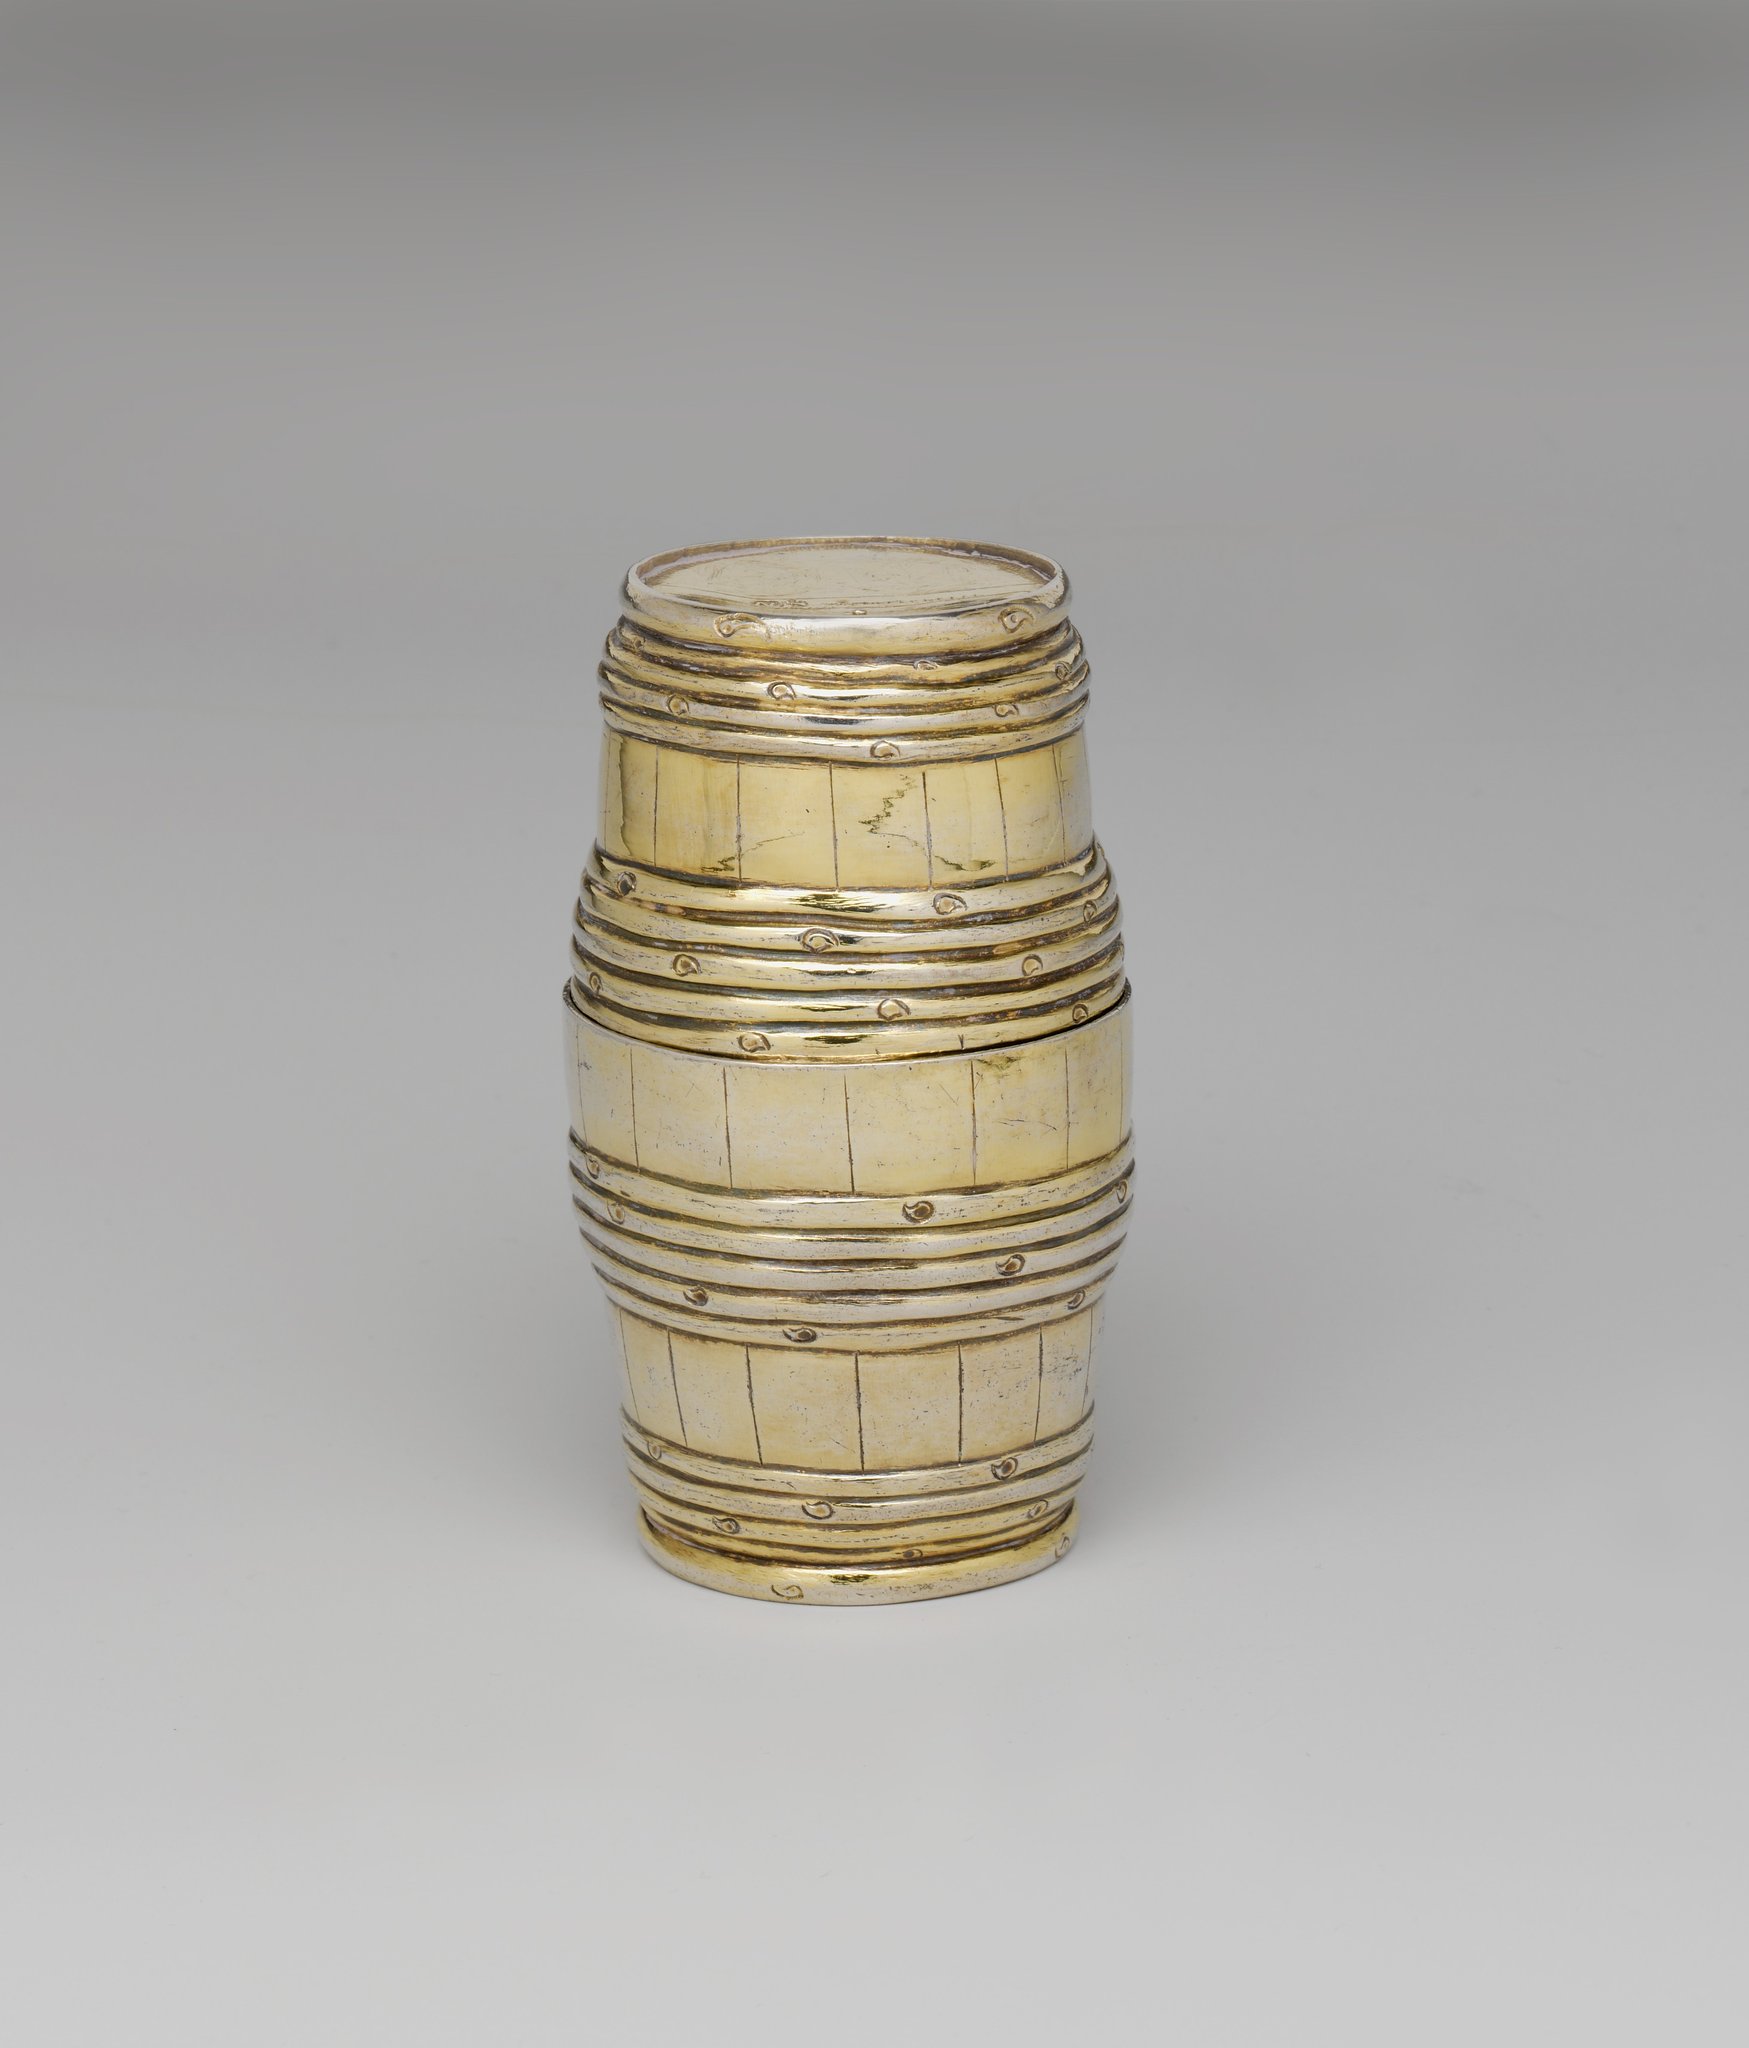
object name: double beaker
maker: nicholaus i emmerling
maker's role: maker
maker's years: 1587-1606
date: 1603-1609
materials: silver gilt